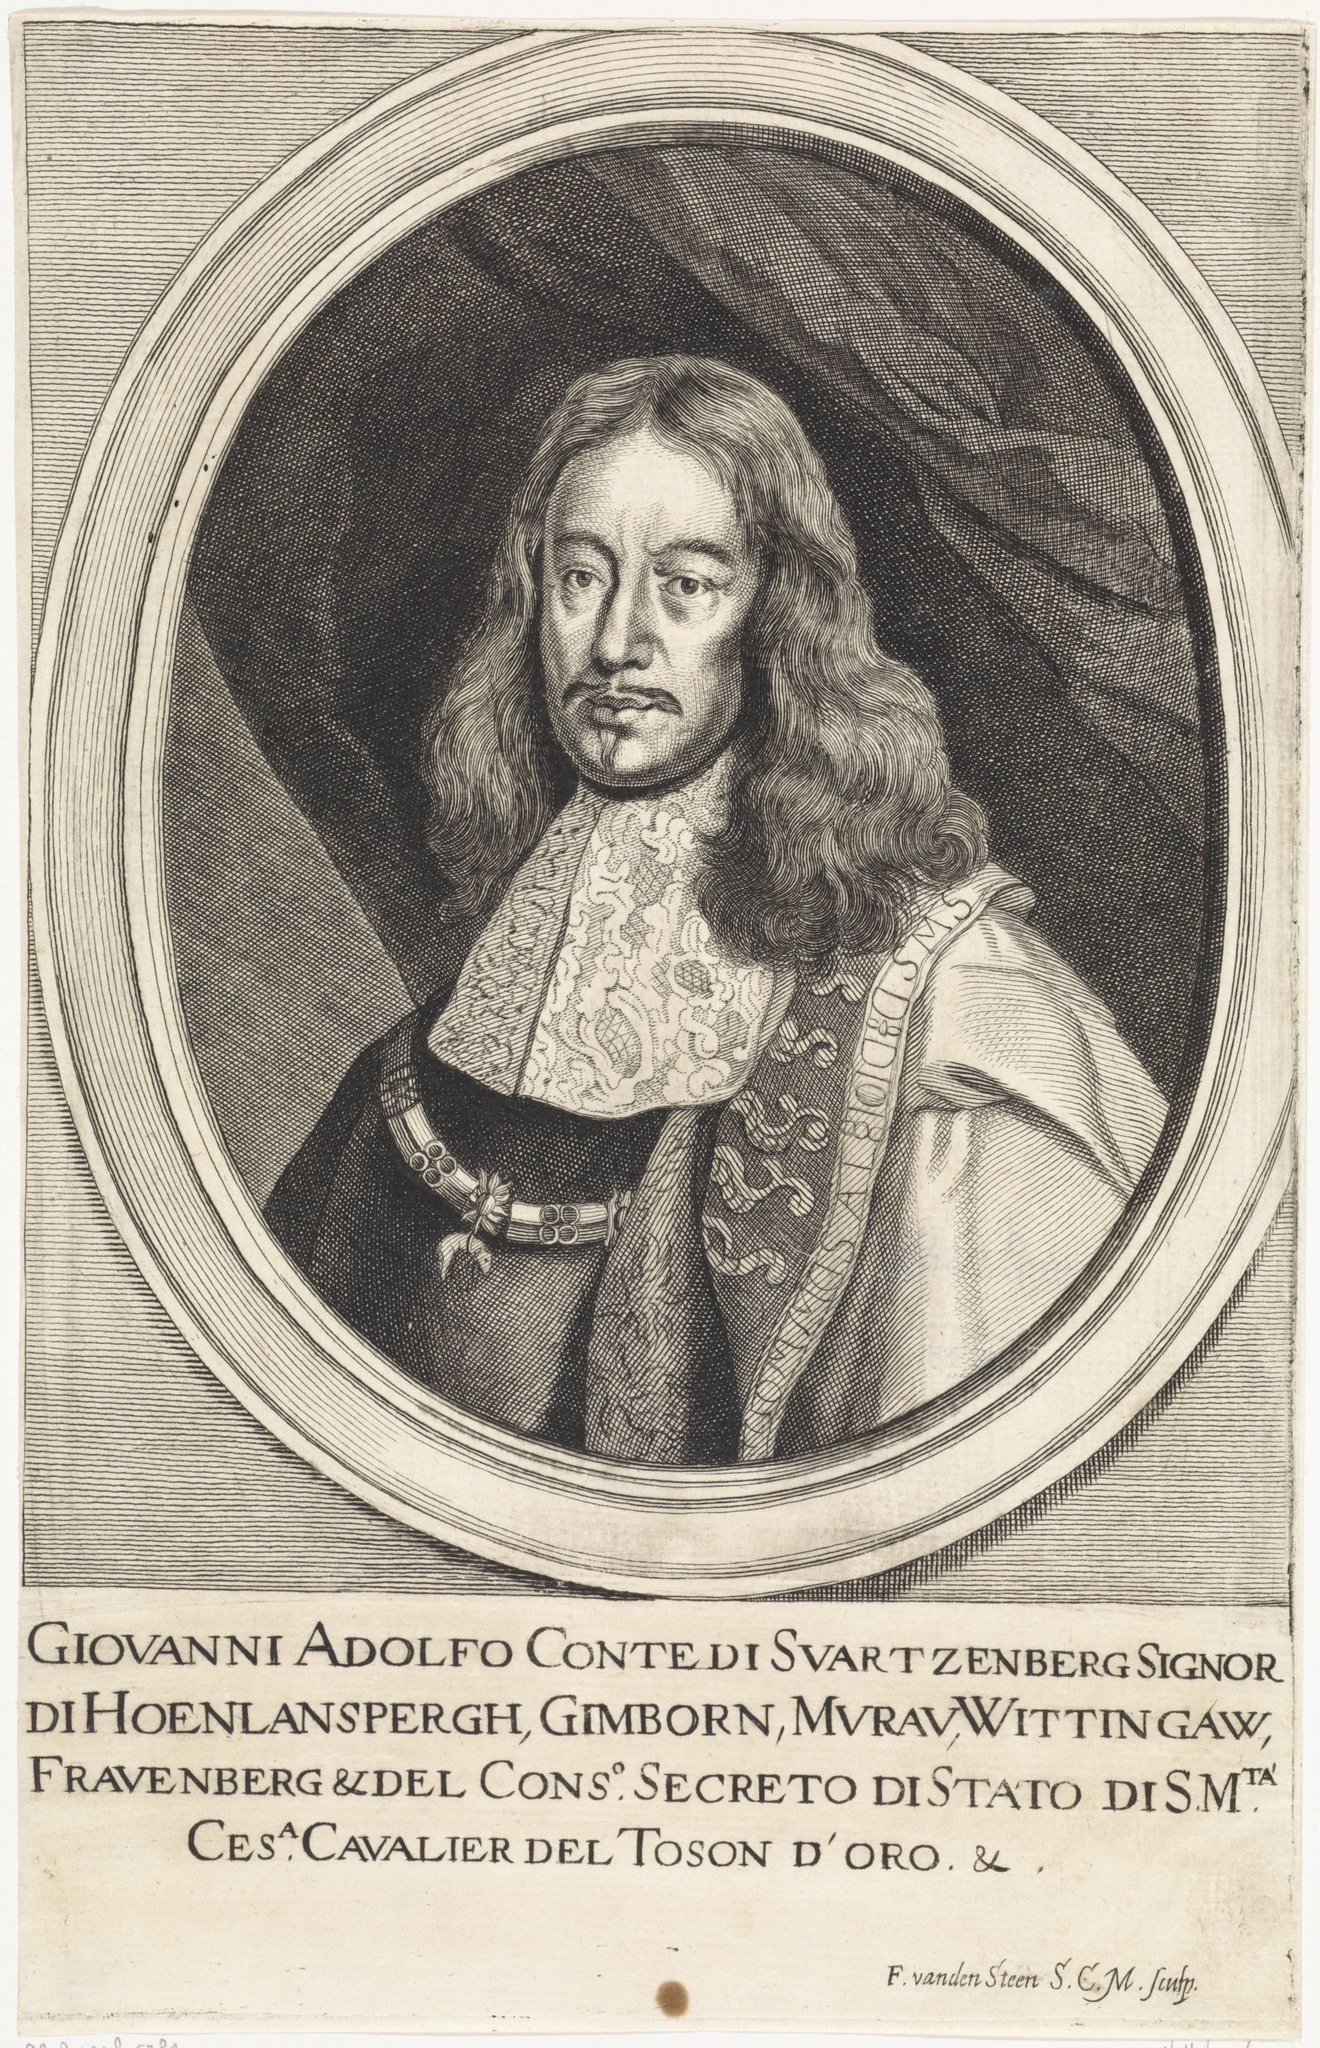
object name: print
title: Portret van Johann Adolf graaf van Schwarzenberg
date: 1670-1674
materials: paper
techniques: engraving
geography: vienna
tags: johann adolf schwarzenberg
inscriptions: collector's mark: Lugt 2228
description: Portret van Johann Adolf graaf van Schwarzenberg met aan een ketting op zijn borst het ordeteken van de Orde van het Gulden Vlies. Onderaan in de marge een vierregelige tekst in het Italiaans.